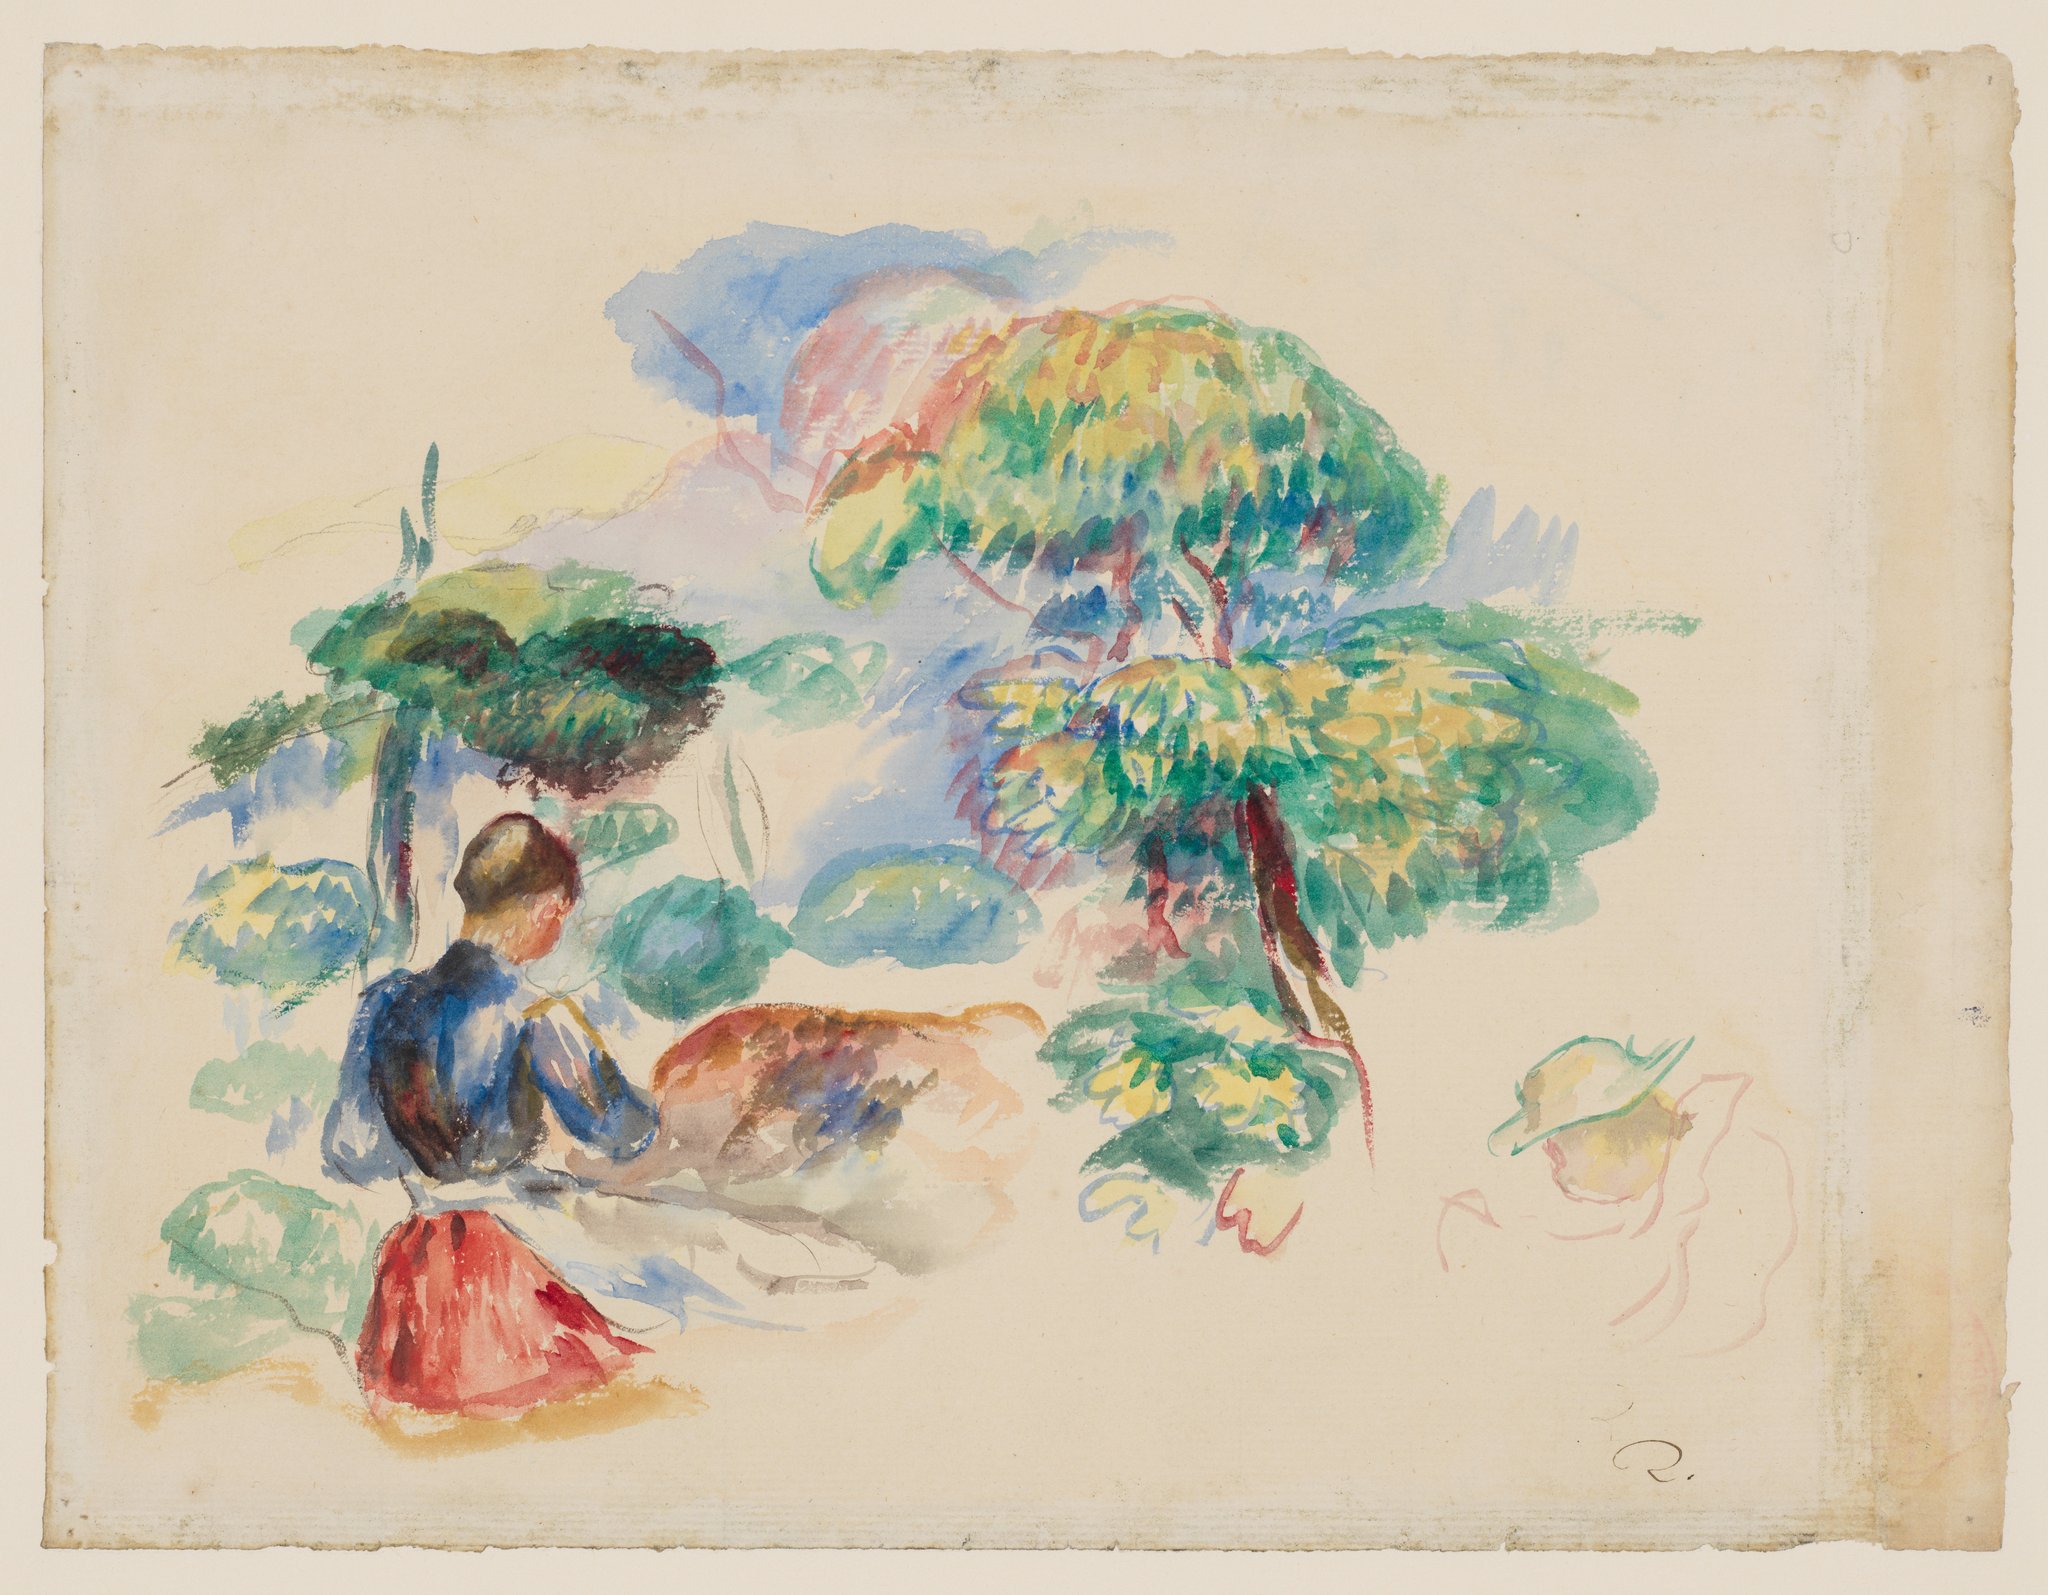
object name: drawing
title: Landscape with a Girl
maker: pierre auguste renoir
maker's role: artist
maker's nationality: french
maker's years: 1841-1919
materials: graphite, paper, watercolor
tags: girls,trees